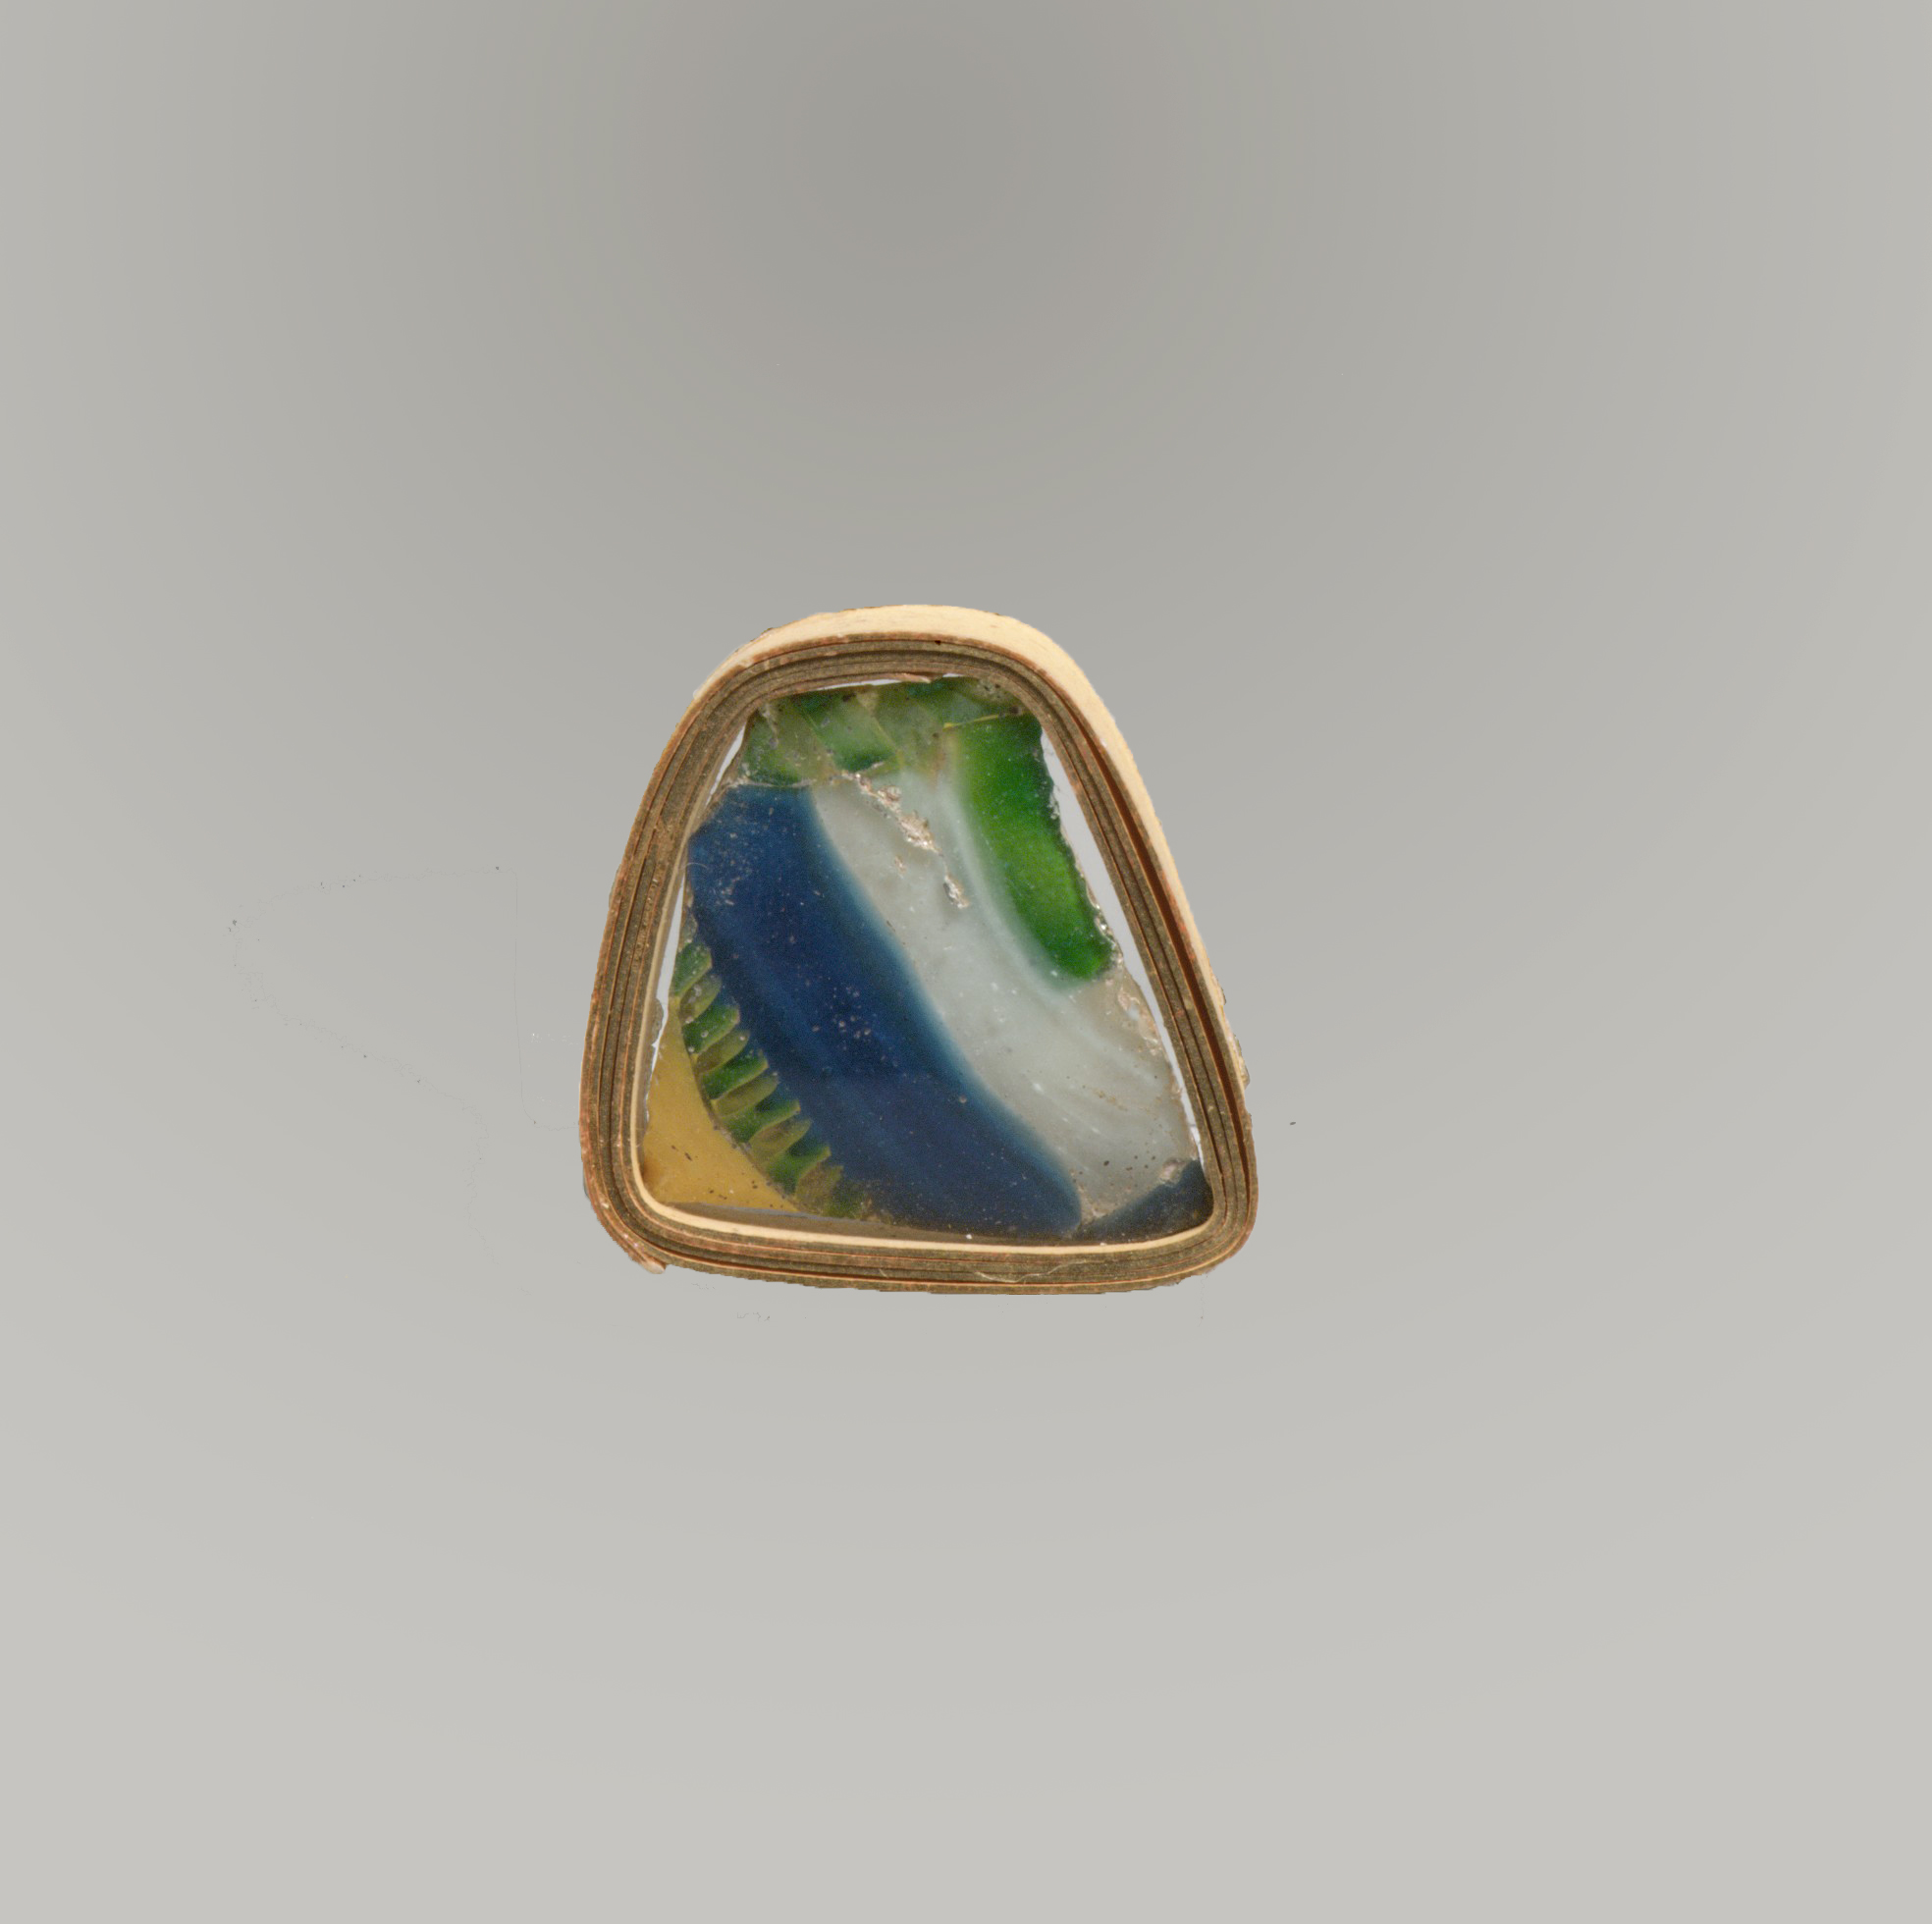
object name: fragment, striped mosaic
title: Glass striped mosaic bowl fragment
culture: roman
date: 34 BCE-33 CE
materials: glass